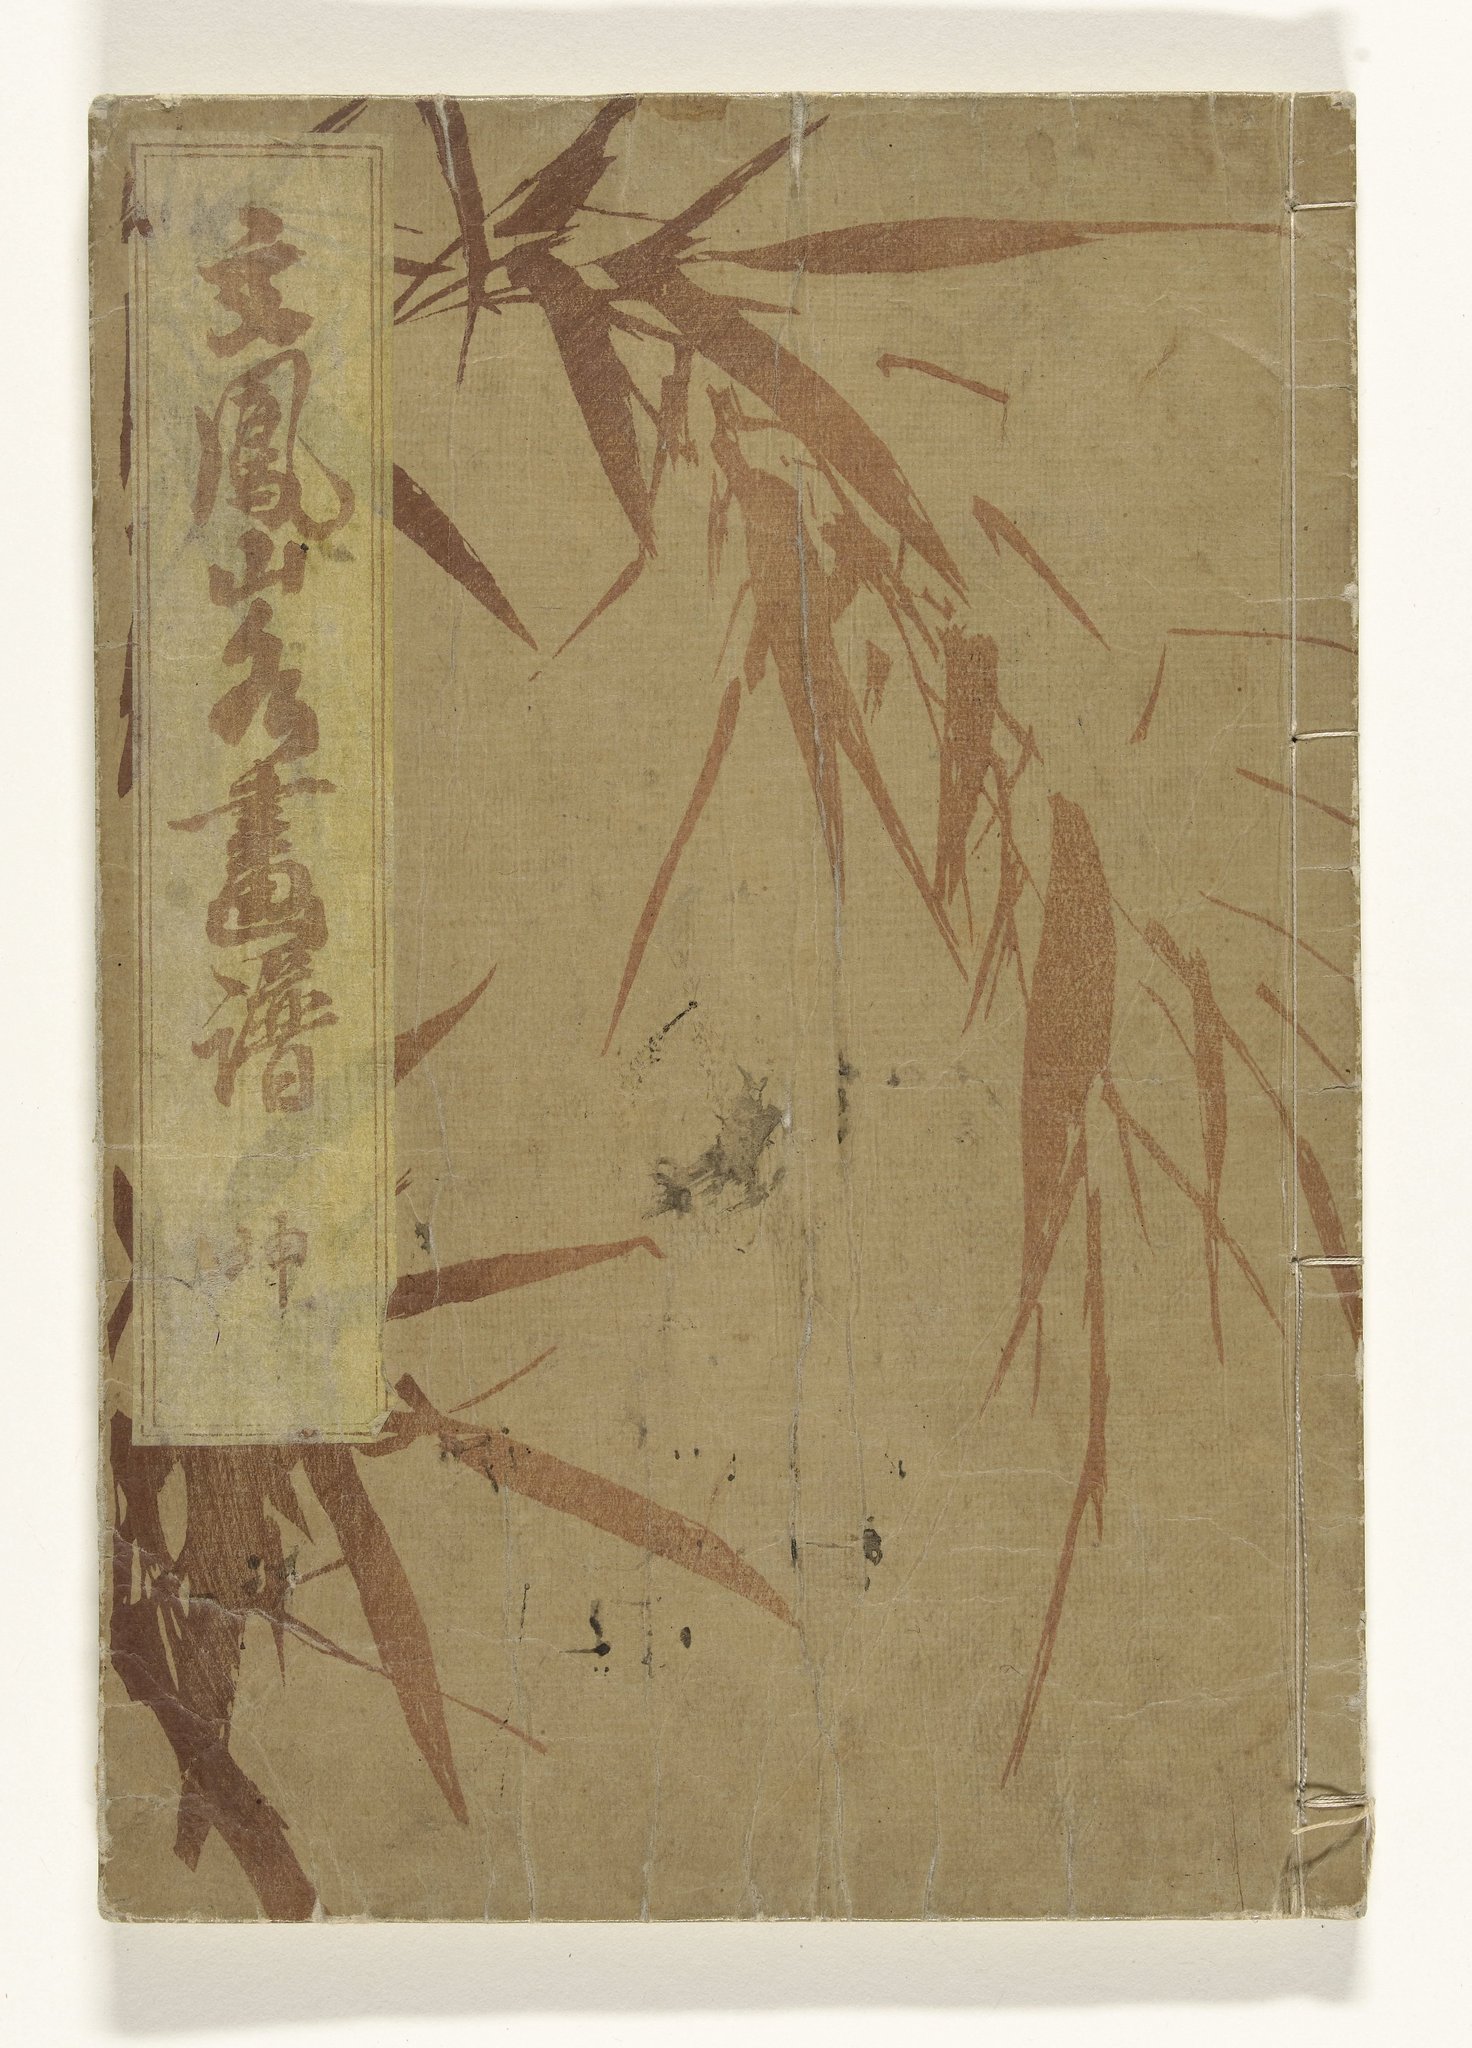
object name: book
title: Bunpo sansui gafu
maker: kawamura bunpo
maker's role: print maker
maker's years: 1779-1821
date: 1824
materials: paper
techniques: woodcut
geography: kyoto